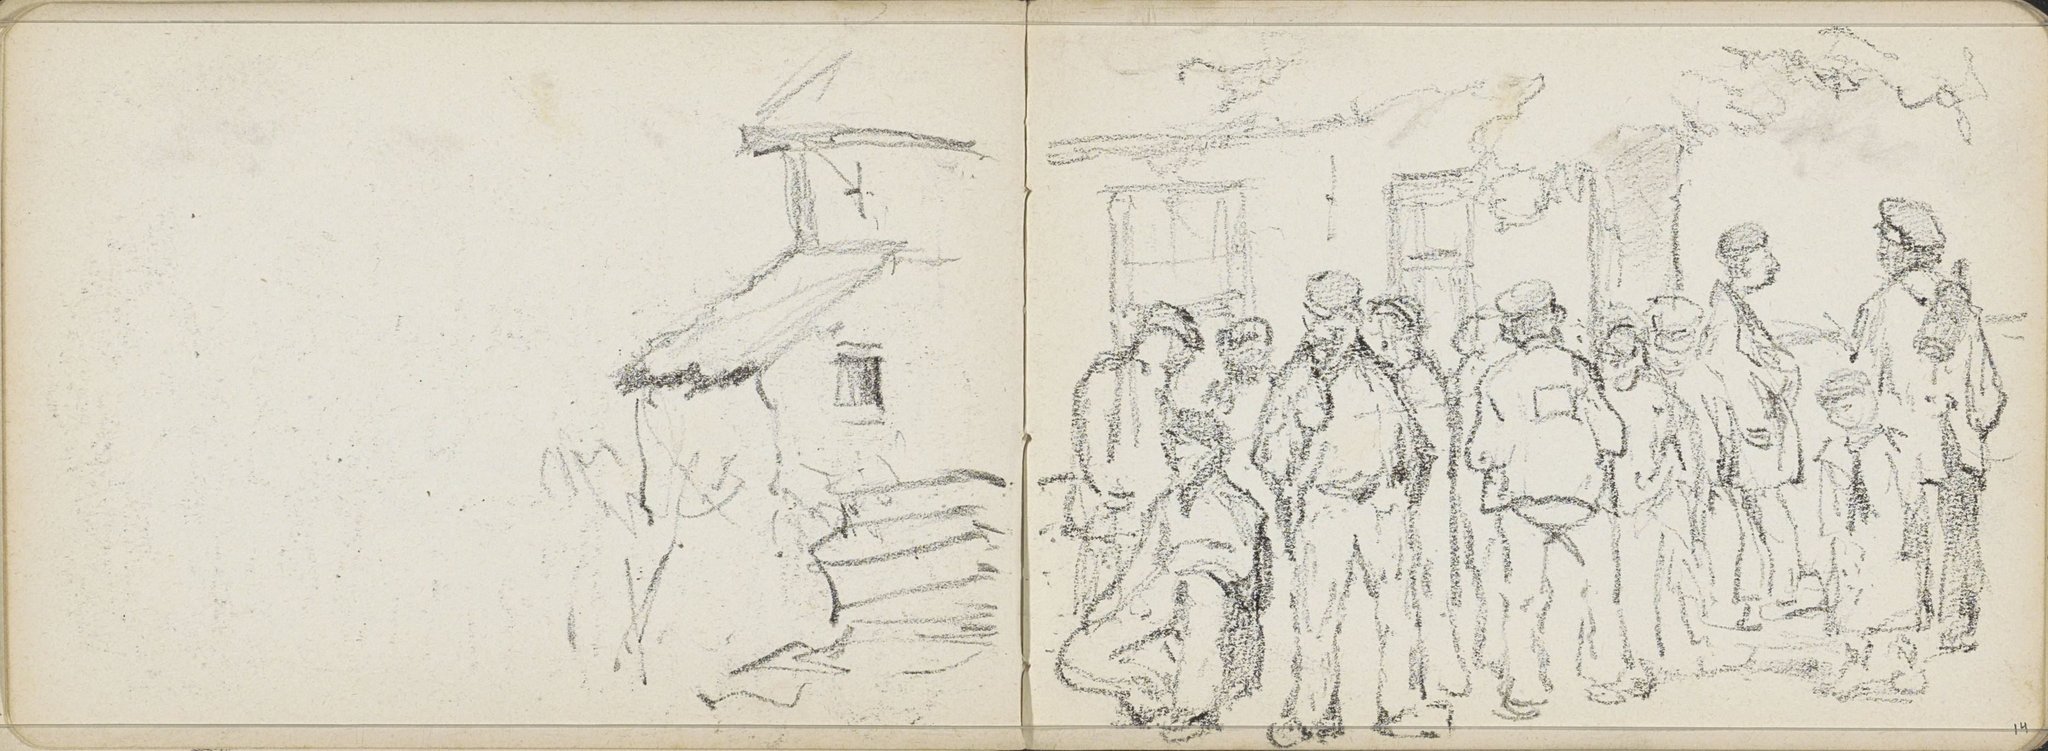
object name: sketchbook leaf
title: Groep mannen op een straat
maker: willem cornelis rip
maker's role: draughtsman, painter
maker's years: 1856-1922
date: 1866-1922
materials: chalk, paper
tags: village street (+ city(-scape) with figures, staffage)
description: De mannen staan voor een gebouw, mogelijk een café of herberg. Blad 13 verso en 14 recto uit een schetsboek met 42 bladen.